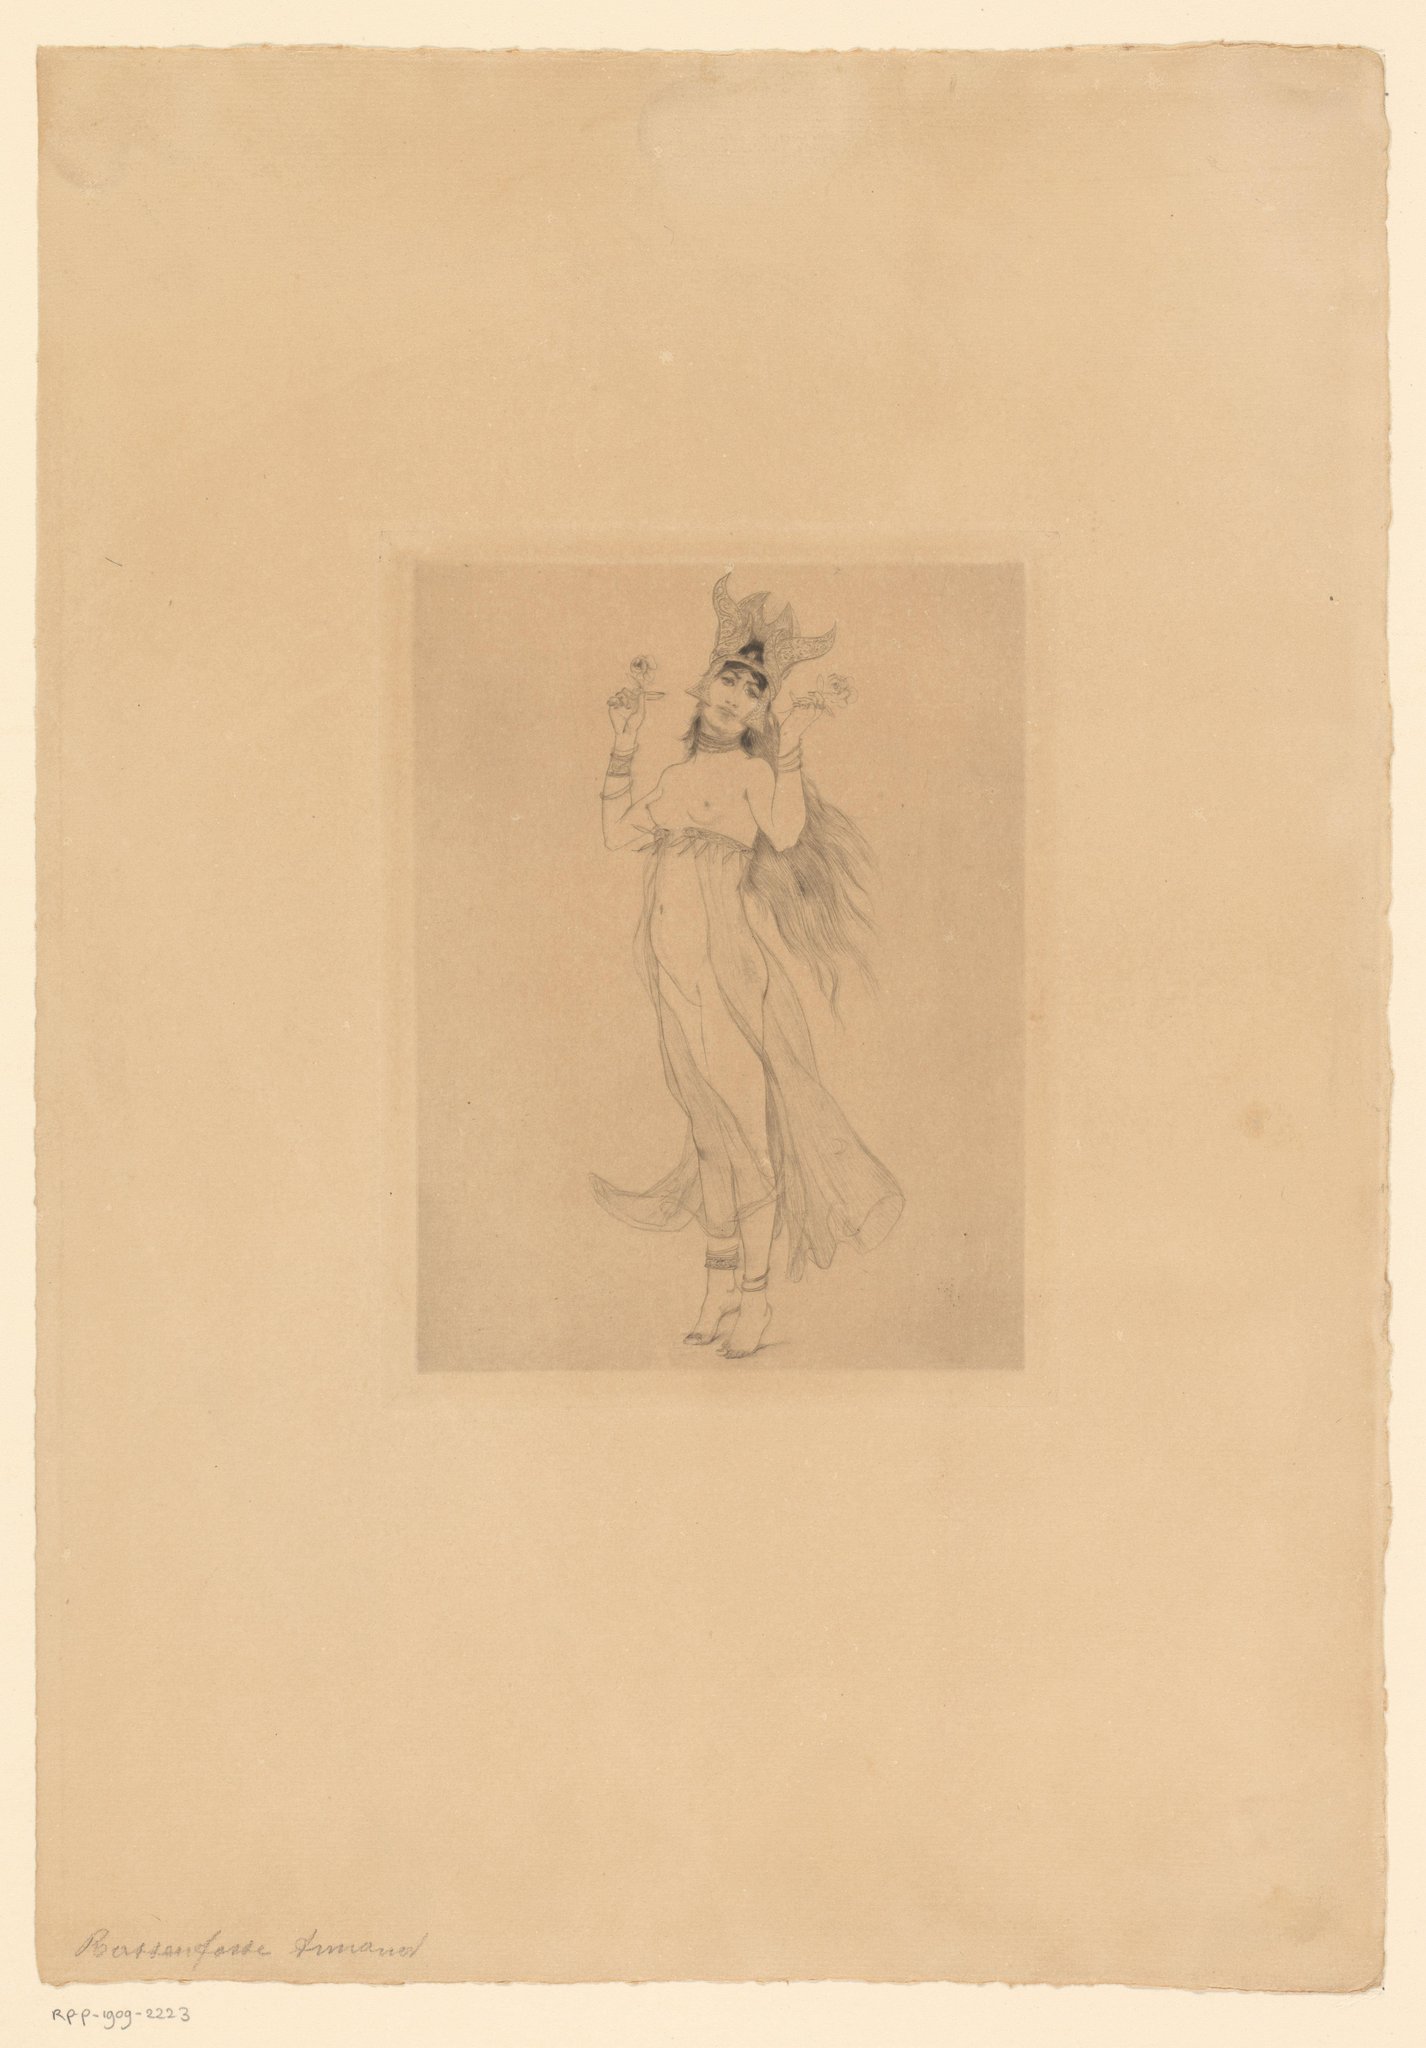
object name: print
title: Salome met Javaans hoofddeksel en bloemen in haar handen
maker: armand rassenfosse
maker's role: draughtsman, painter, print maker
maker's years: 1862-1934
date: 1895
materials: paper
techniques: drypoint, intaglio, roulette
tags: (showing oneself) undressed, quasi-nude, salome (not in biblical context), woman dancing alone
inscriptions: collector's mark: Lugt 2228